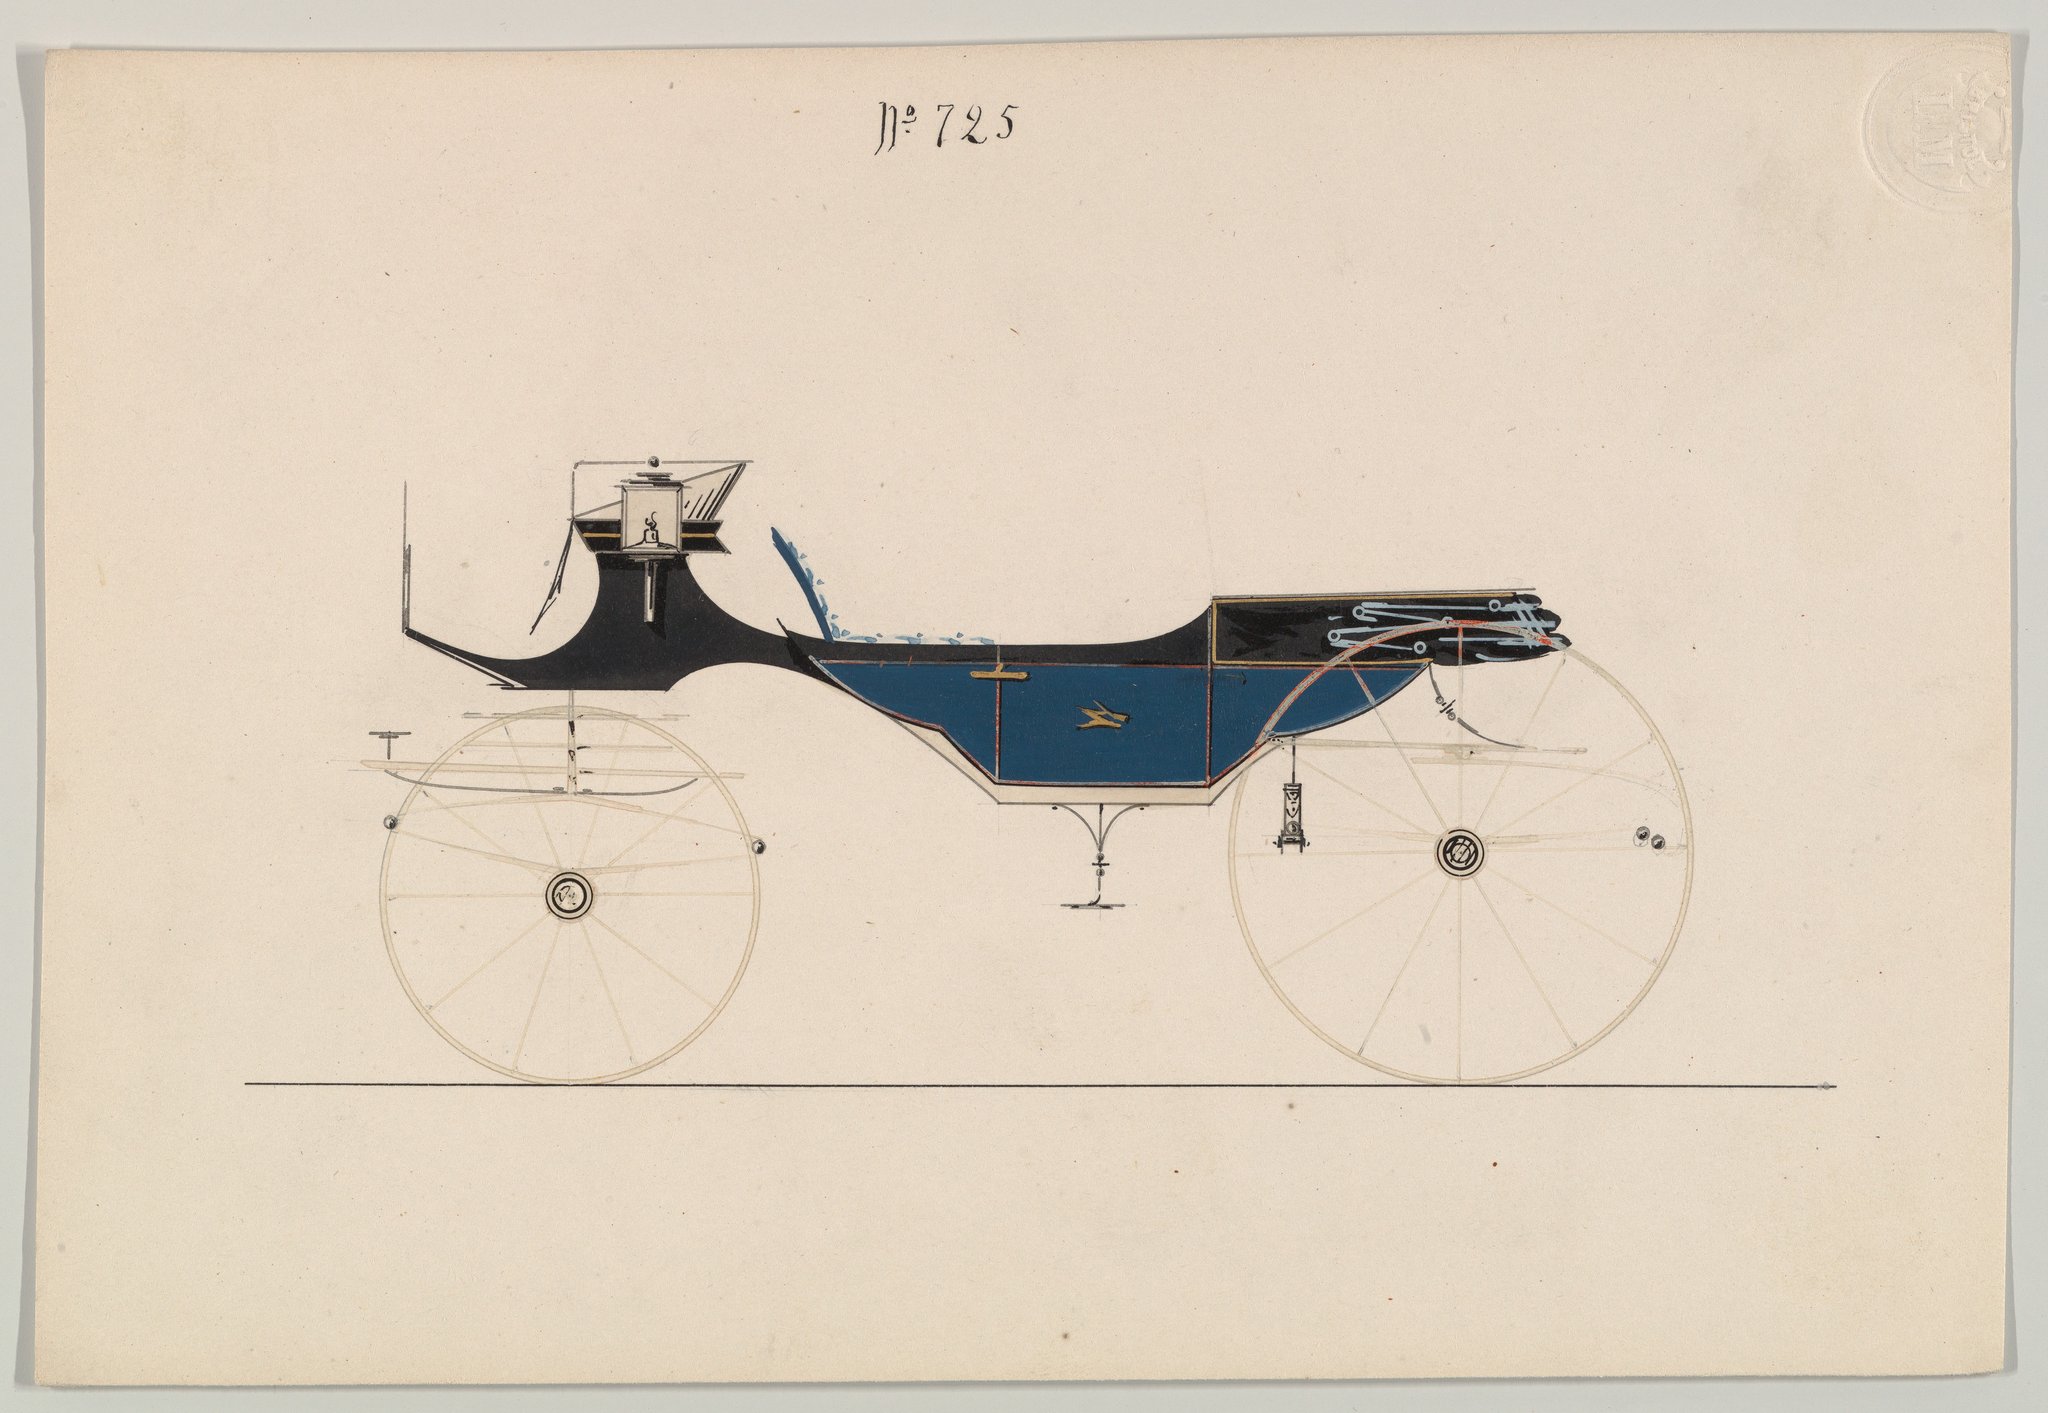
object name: drawing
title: Design for Vis-à-vis/ Caleche, no. 725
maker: brewster & co.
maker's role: manufacturer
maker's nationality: american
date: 1850-1870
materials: gouache, gum arabic, watercolor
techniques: pen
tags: carriages